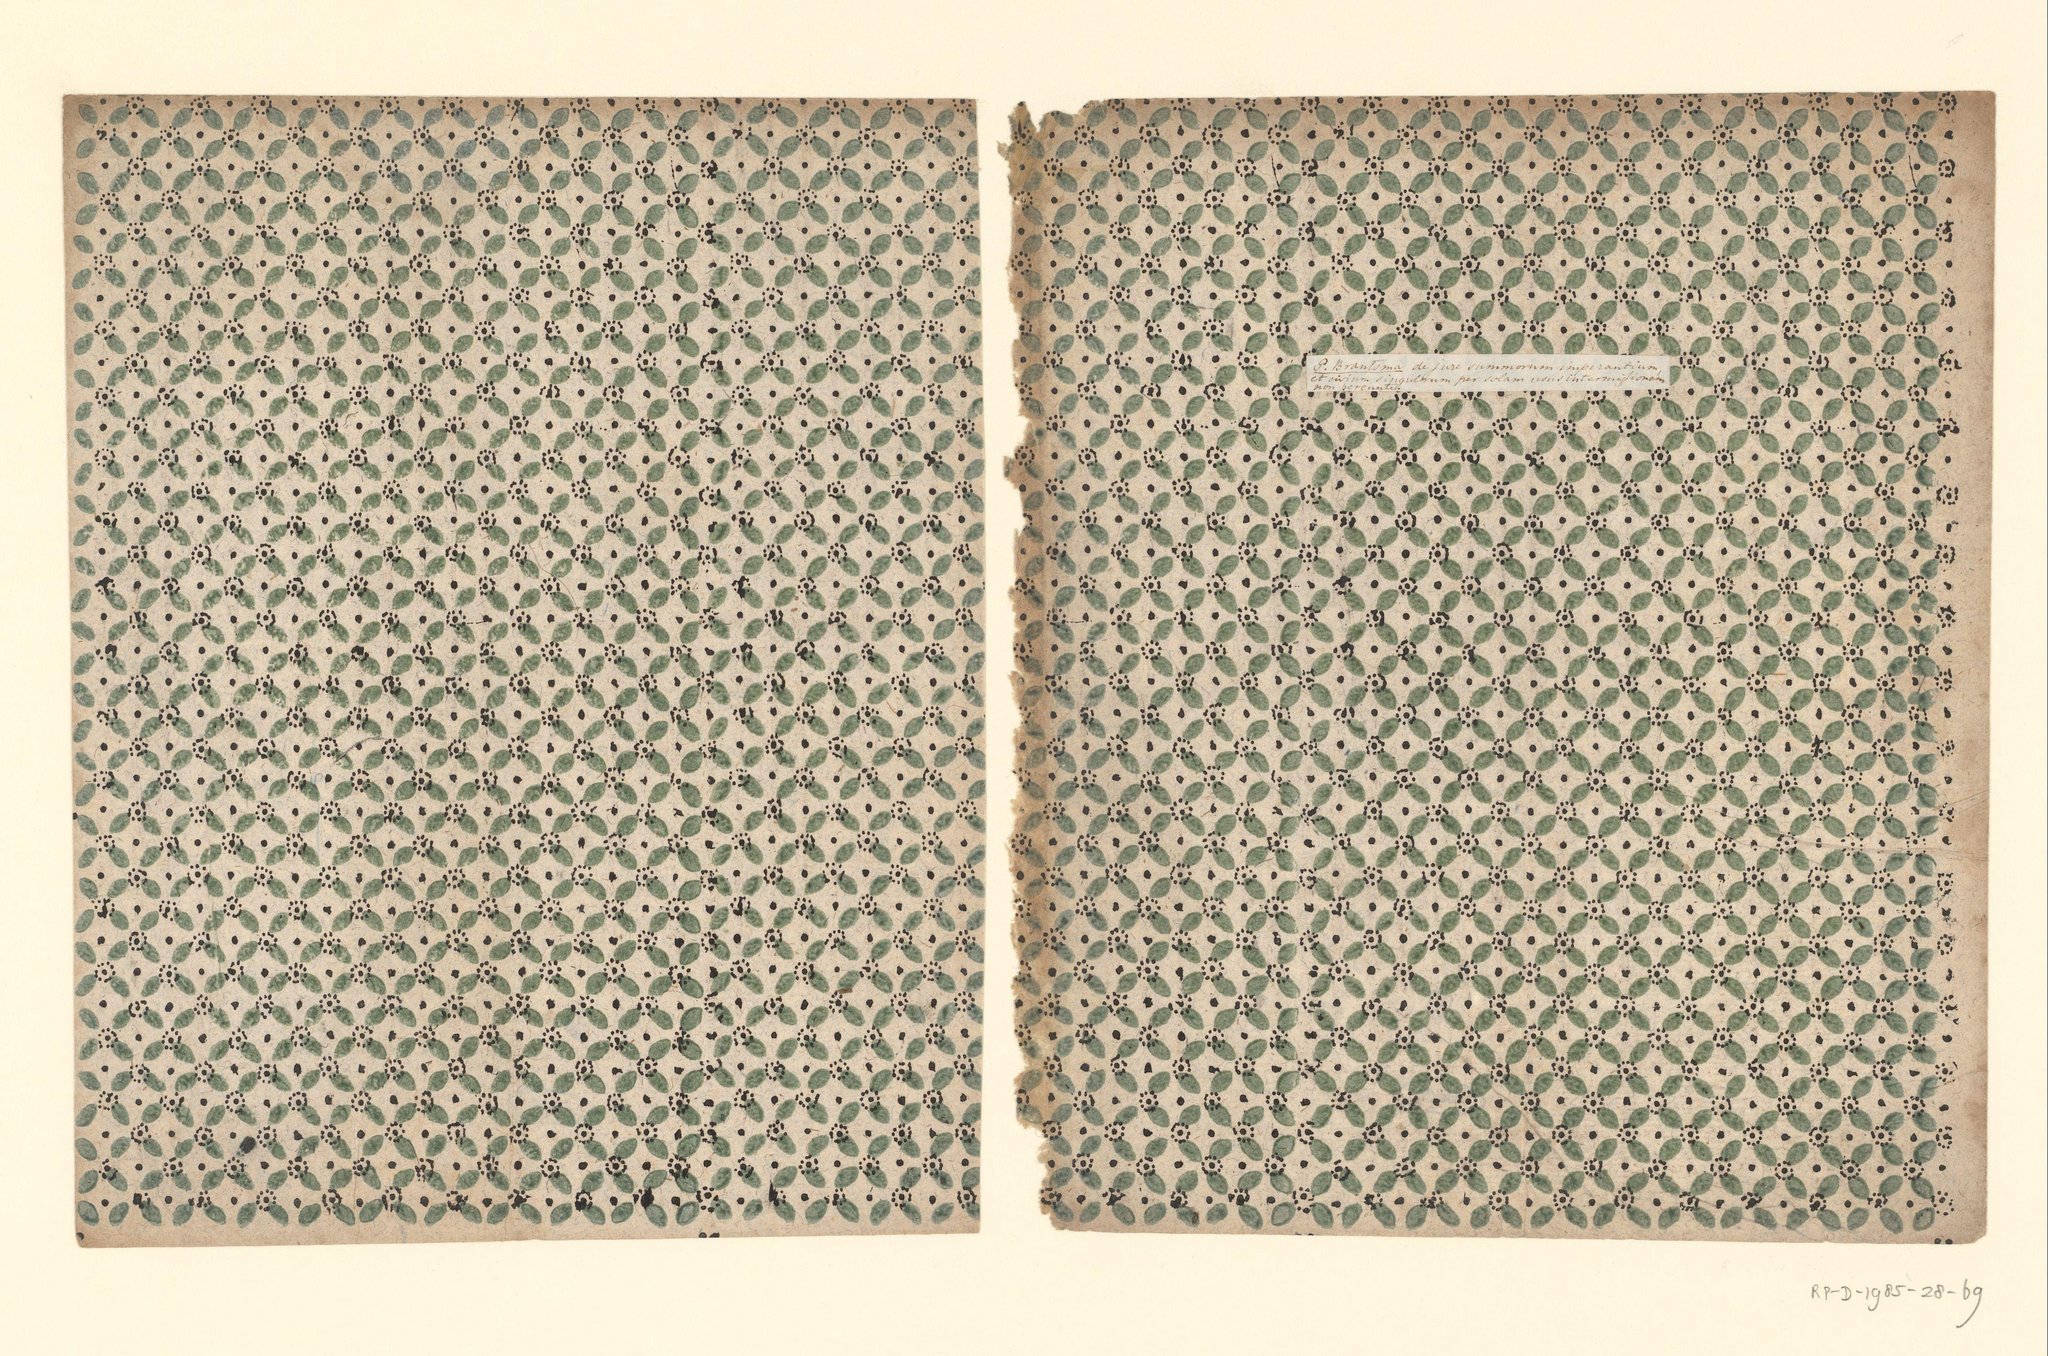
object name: wrapper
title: Twee bladen met ruitenpatroon van bladeren met overhoeks motief bestaande uit cirkel van punten en stip als veldvulling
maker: Anonymous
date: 1750-1900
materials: paper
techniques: printing block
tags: ornament derived from plant forms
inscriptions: collector's mark: Lugt 2760, collector's mark: Lugt 2228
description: Twee bladen met ruitenpatroon van bladeren met overhoeks motief bestaande uit cirkel van punten en stip als veldvulling. Met etiket met opschrift: 'P. Brantsma ... intermissionem.' Twee losse helften van een omslag.